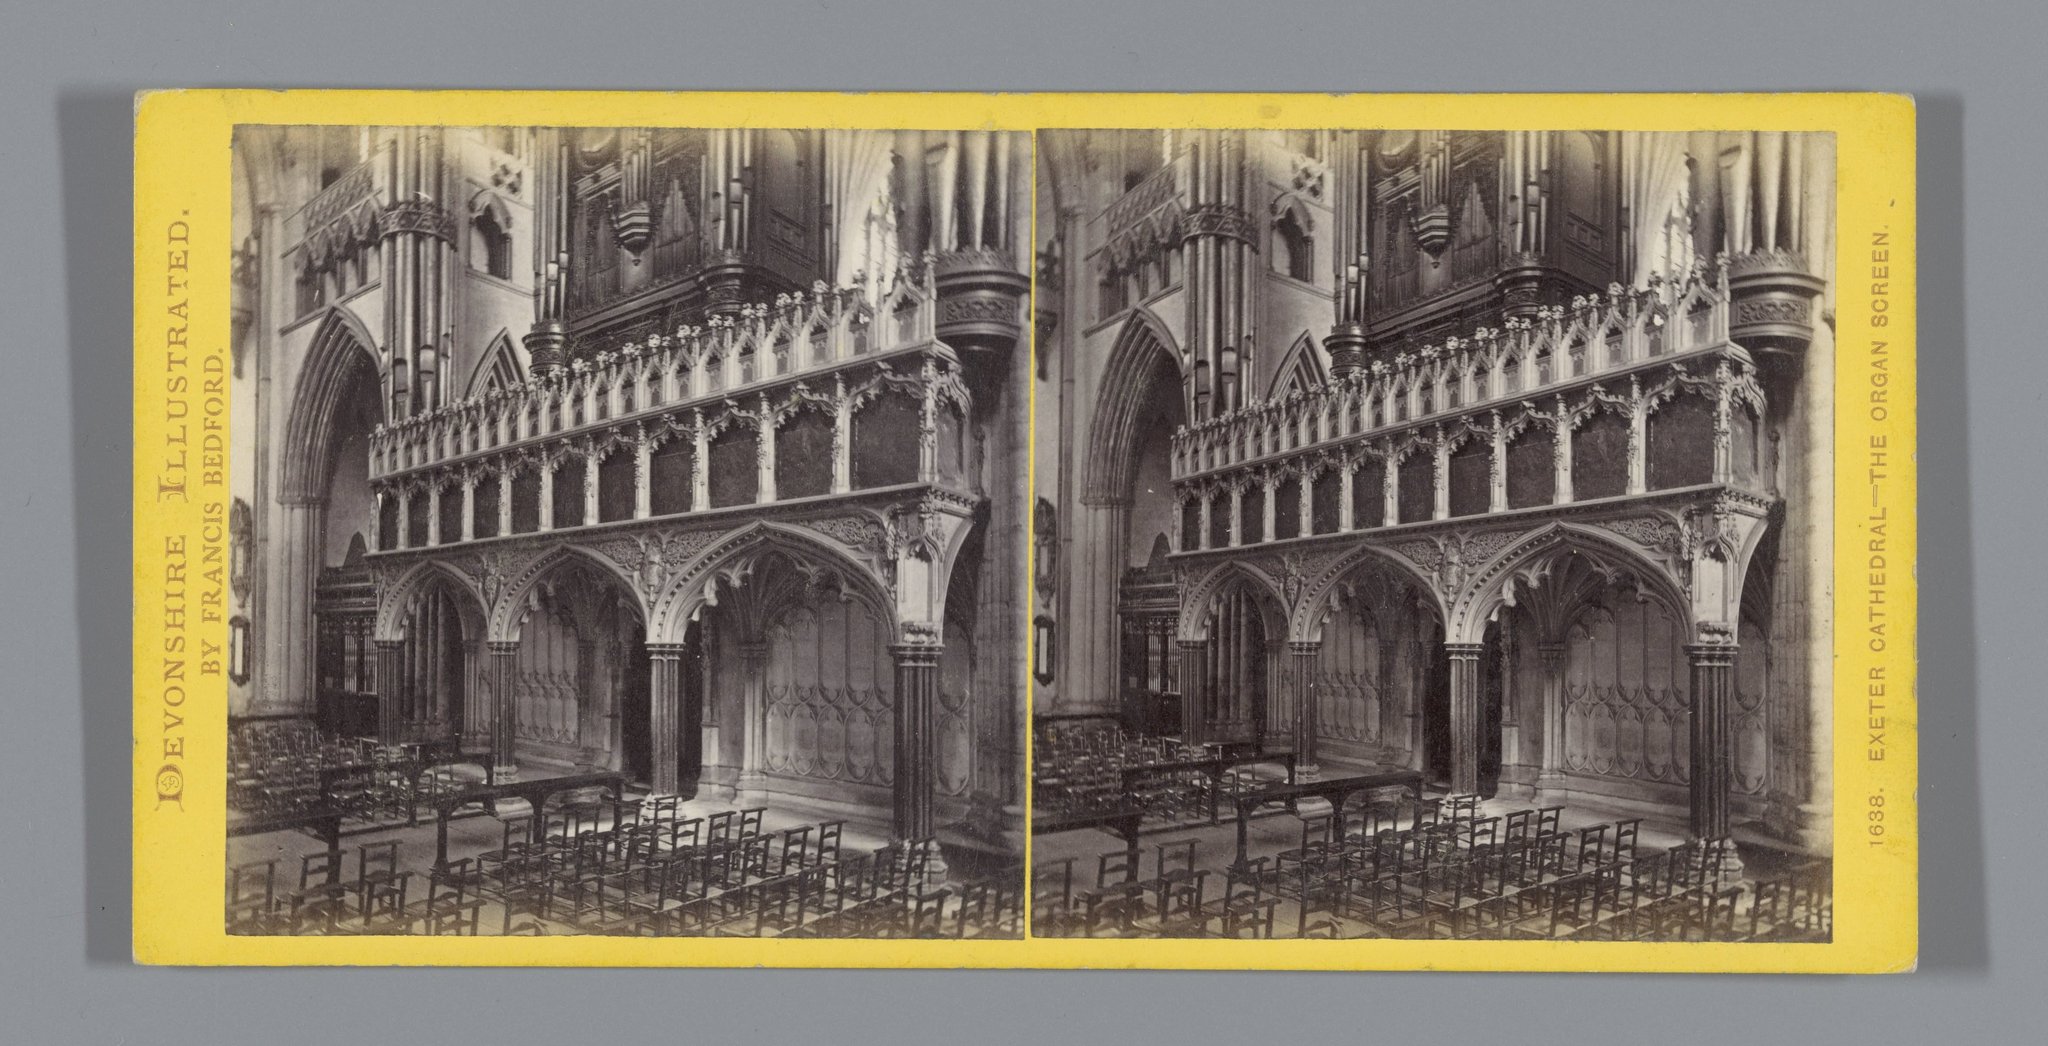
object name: stereograph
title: Oxaal van de Kathedraal van Exeter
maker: francis bedford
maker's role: print maker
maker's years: 1815-1894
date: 1850-1880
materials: cardboard, photographic support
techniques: albumen print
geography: exeter cathedral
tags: rood-screen, choir-screen; iconostasis, interior of church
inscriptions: inscription: ‘Devonshire Illustrated. by Francis Bedford.’, number: ‘1638.’